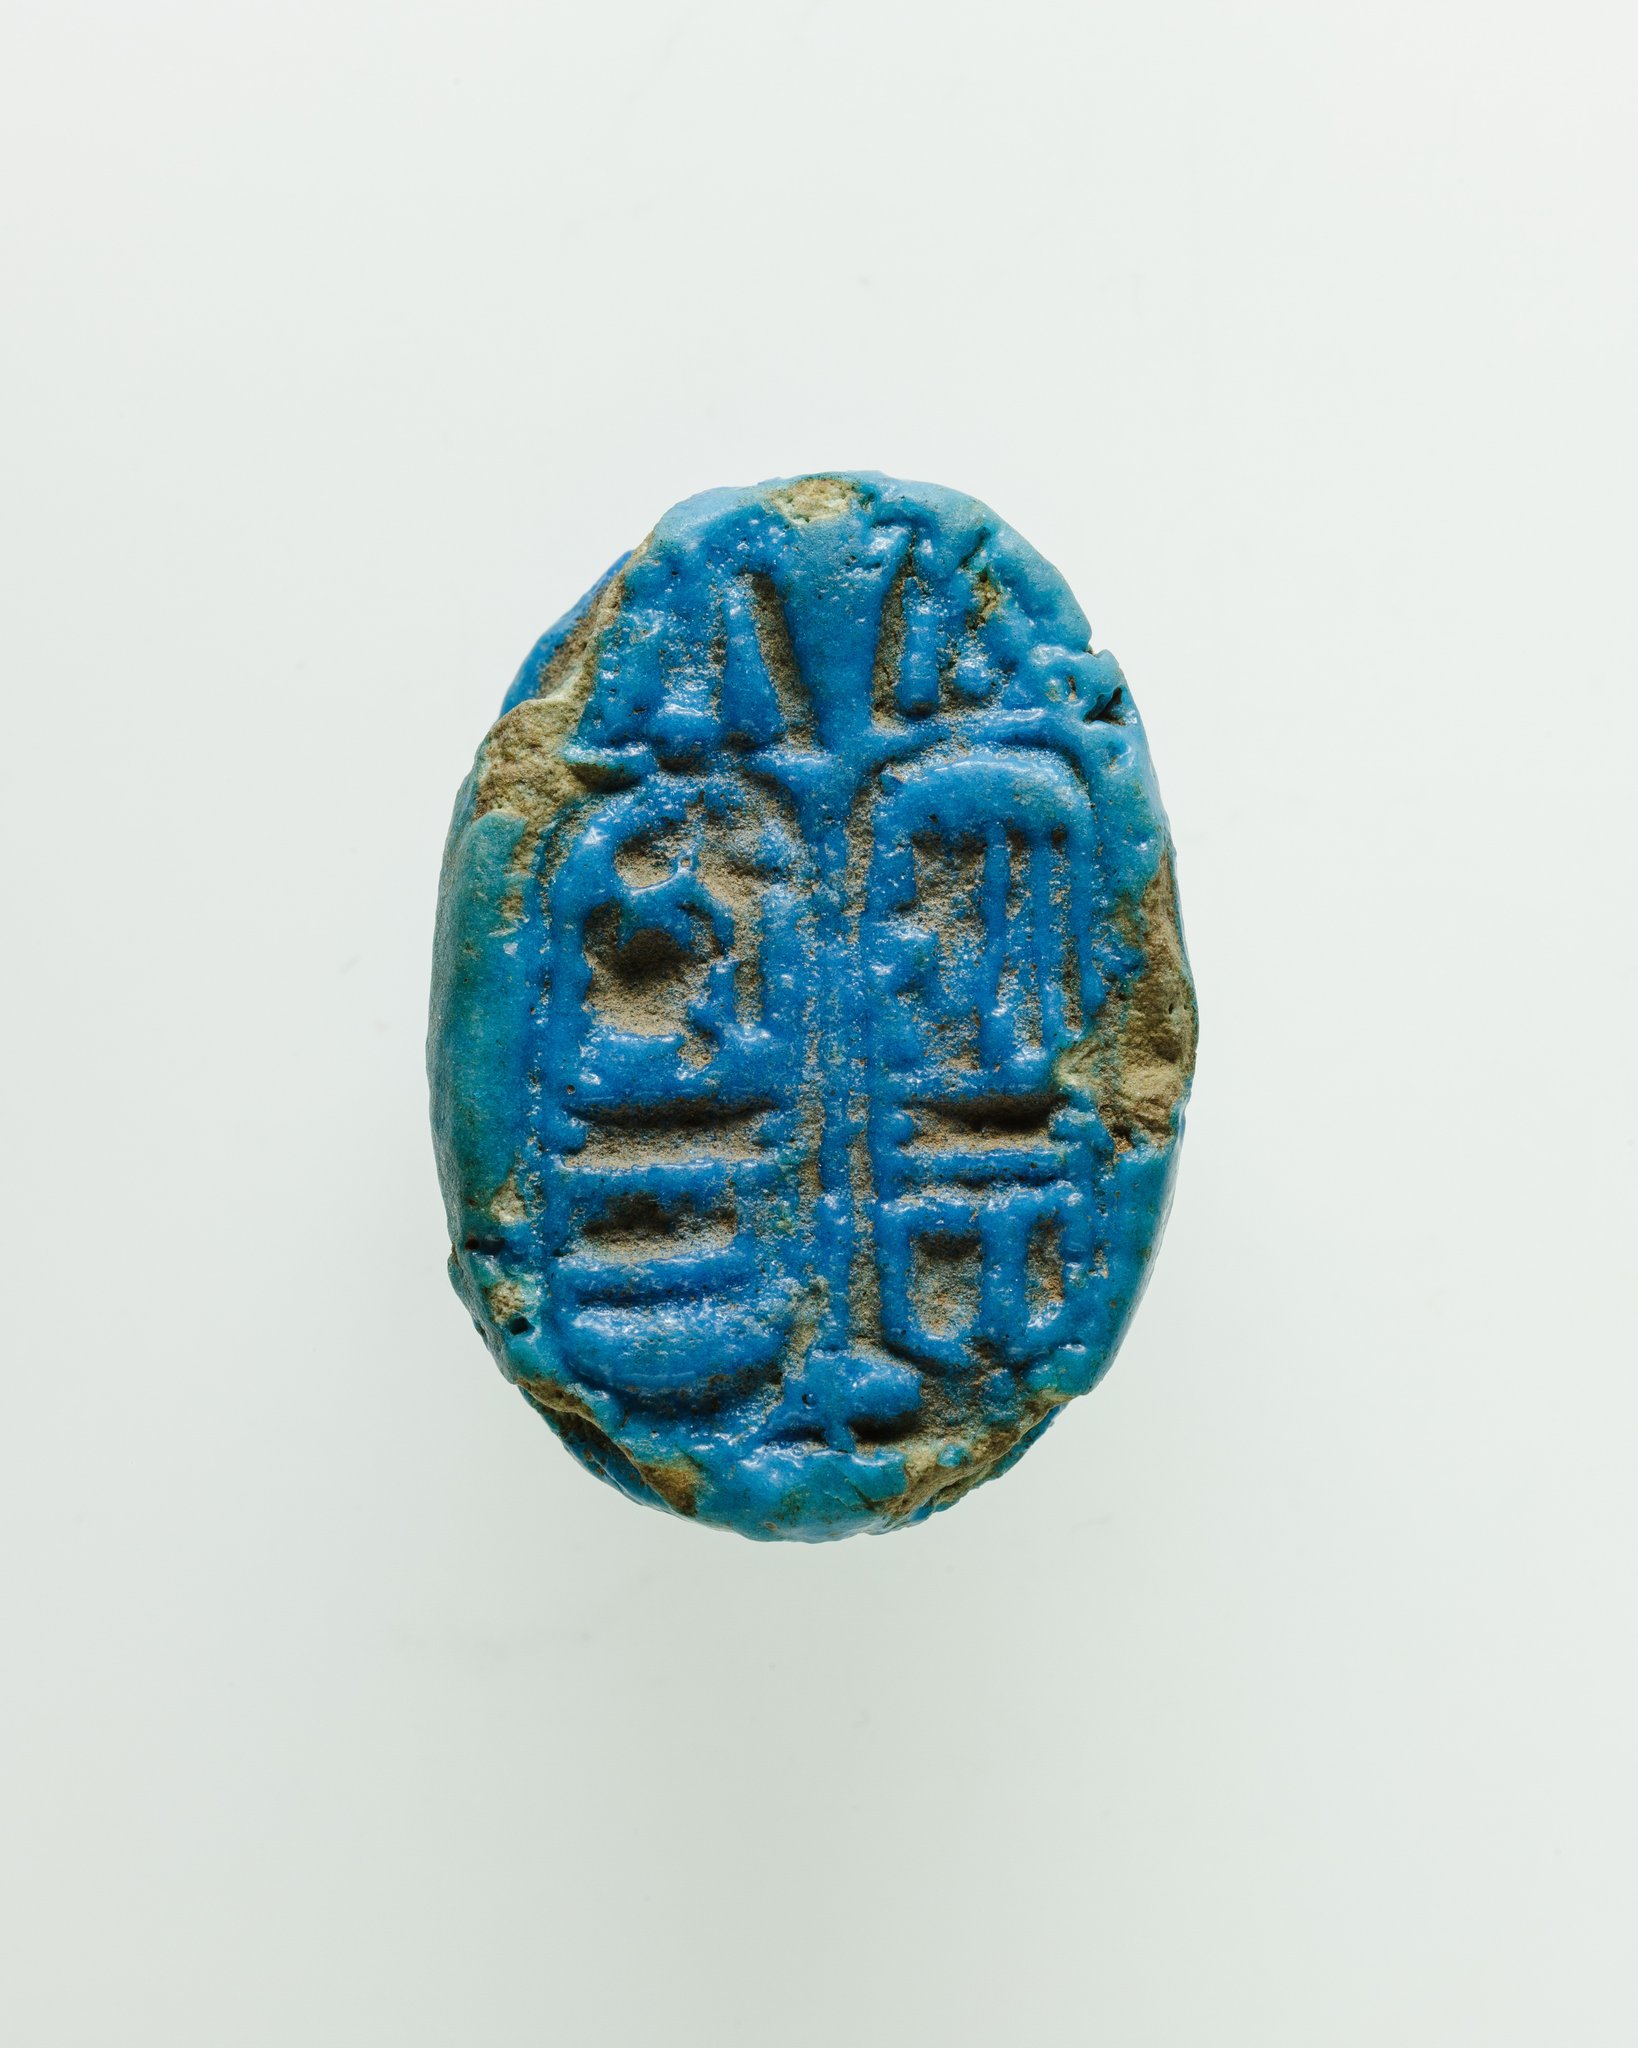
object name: scarab, hieroglyph, cartouche, seti ii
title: Scarab of Seti II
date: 1200-1194 BCE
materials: faience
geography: egypt